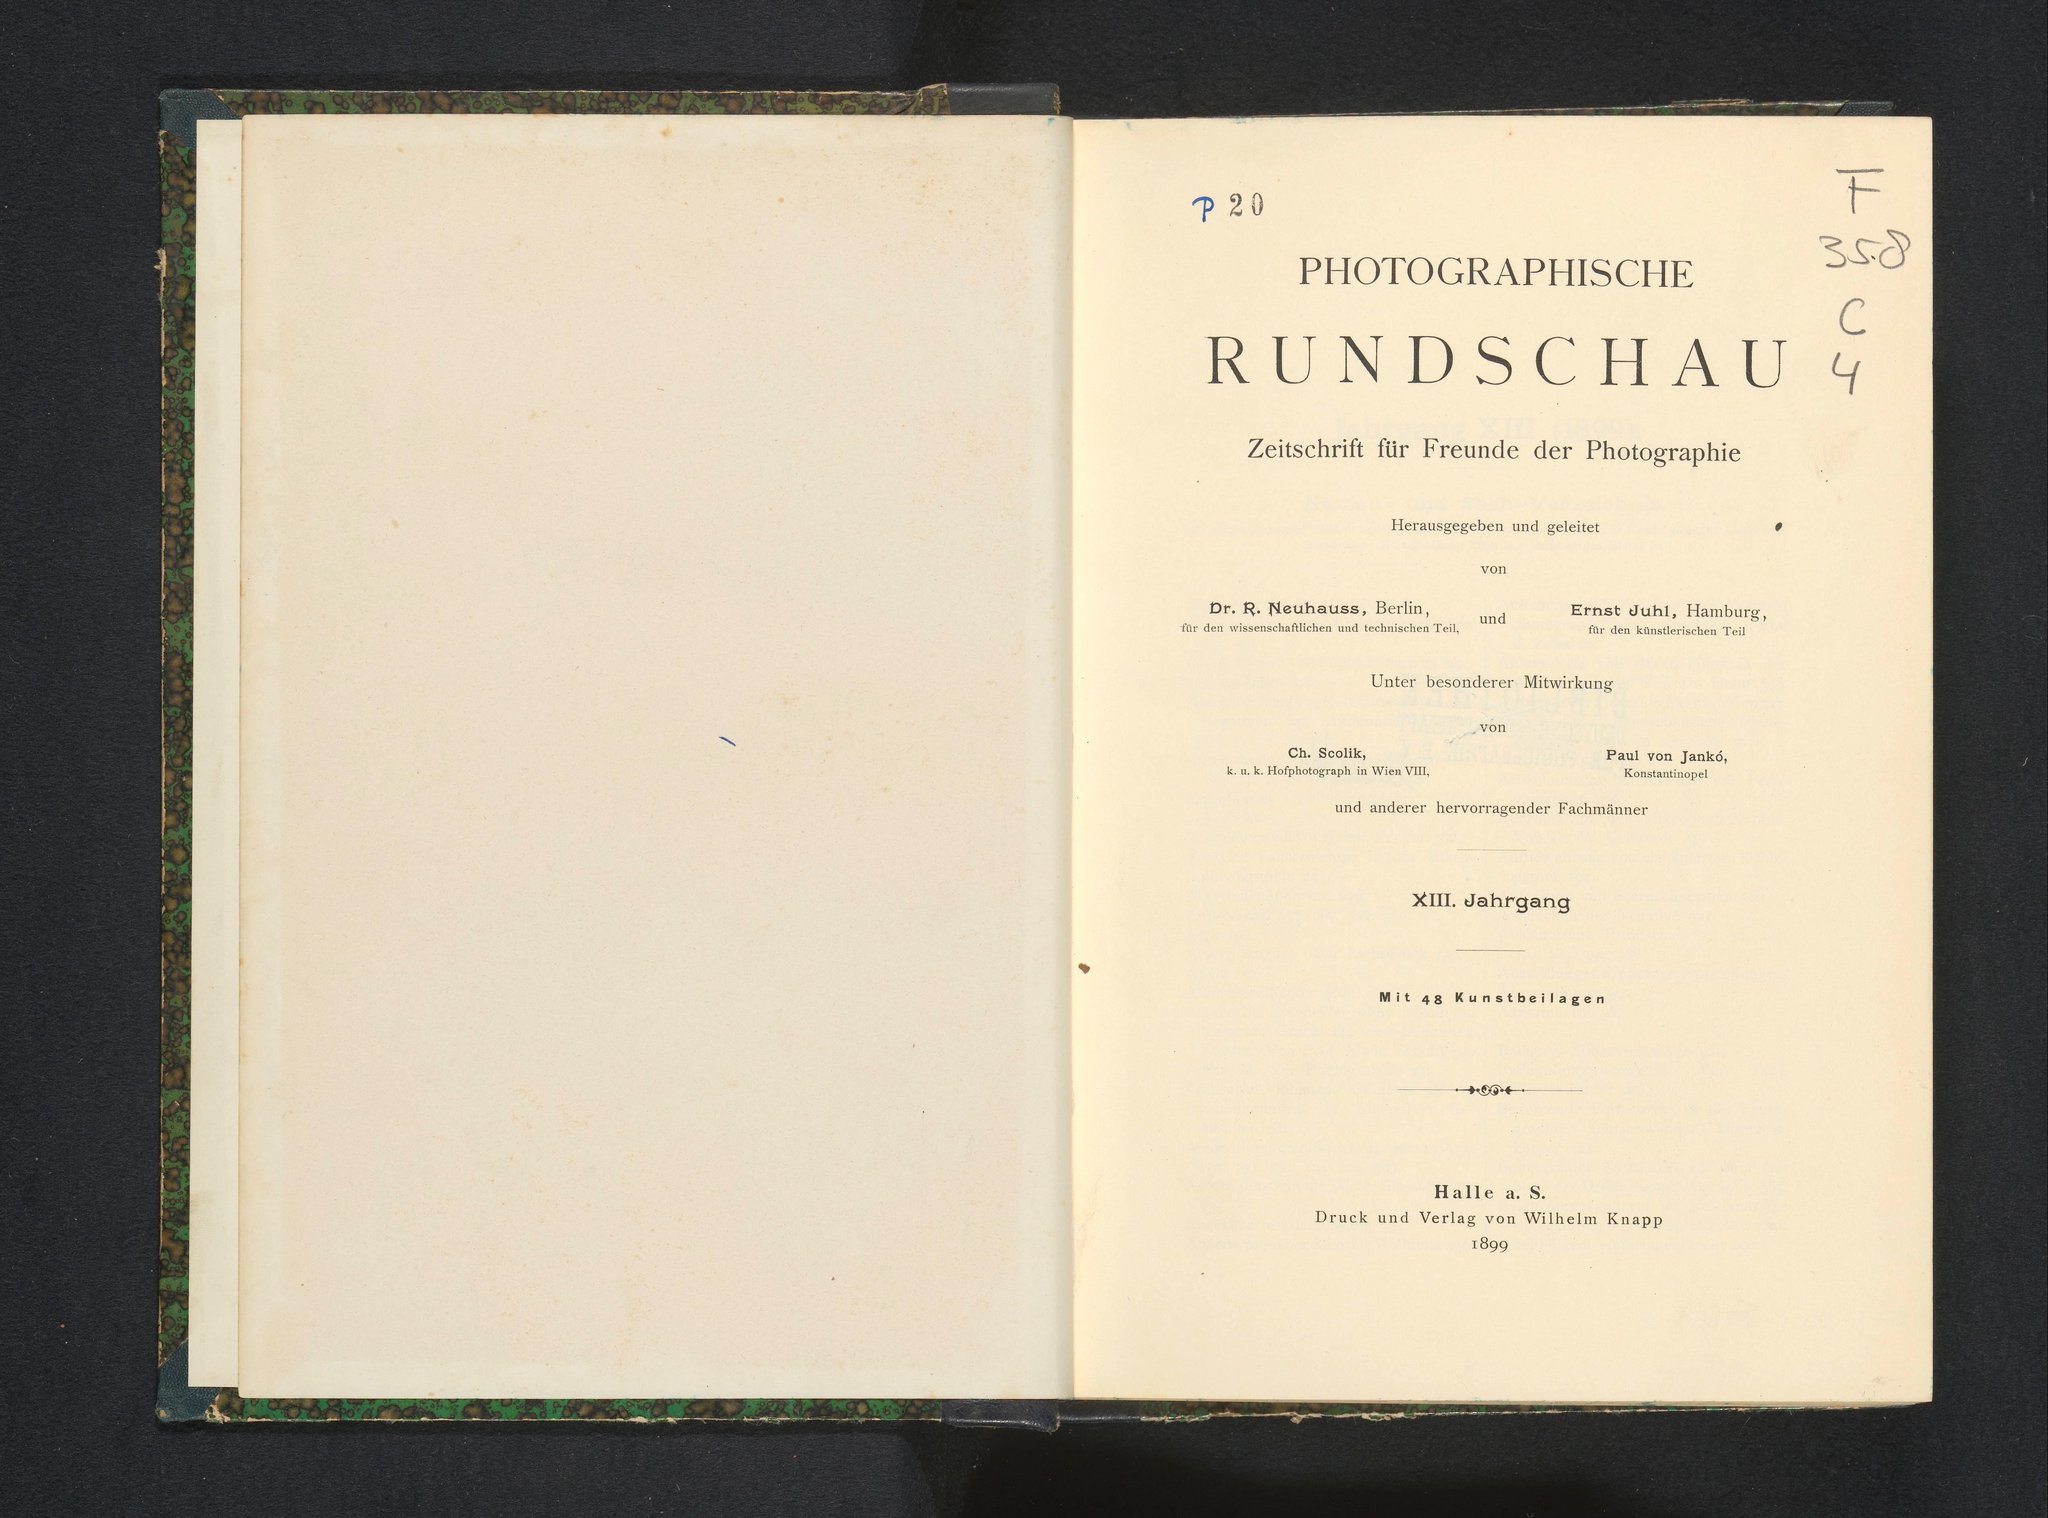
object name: magazine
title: Photographische Rundschau : Zeitschrift für Freunde der Photographie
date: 1899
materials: cardboard, leather, linen, paper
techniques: marbled paper, photoaquatint, printing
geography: halle an der saale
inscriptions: inscription: ‘Bibliothek Deutsche Geselschaft für photographie E.V.’, number: ‘k. 79.’, name: ‘Paul Hanneke’, name: ‘Paul Hanneke’